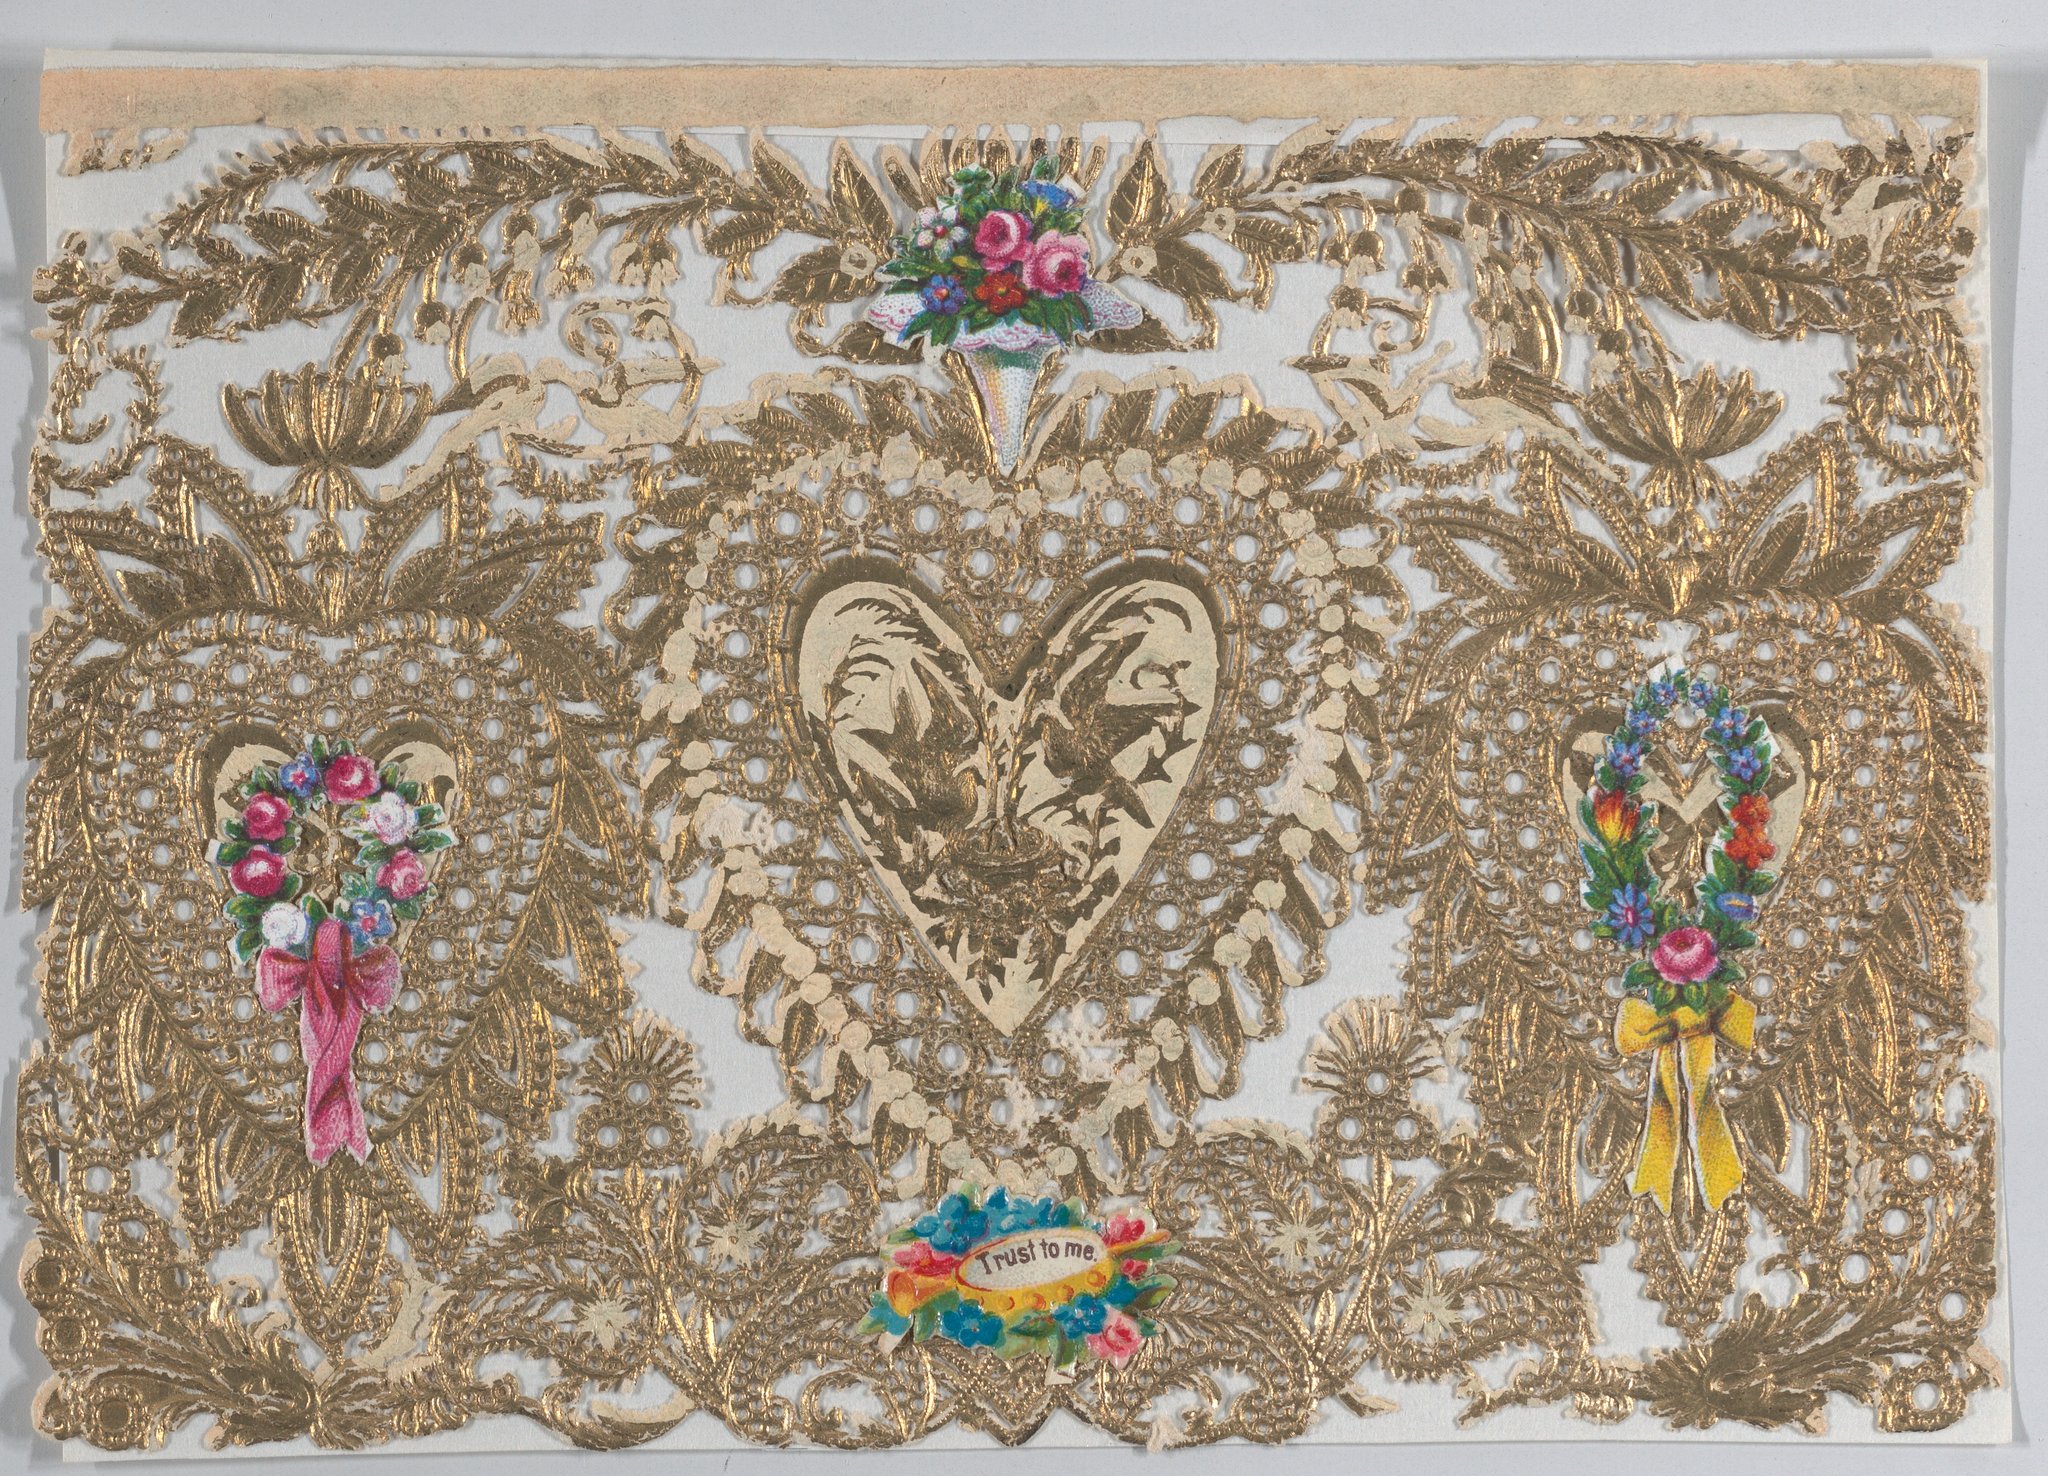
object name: valentine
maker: Anonymous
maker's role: artist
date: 1859-1869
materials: lace, paper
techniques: chromolithography, cutting, embossing, gilding, open work